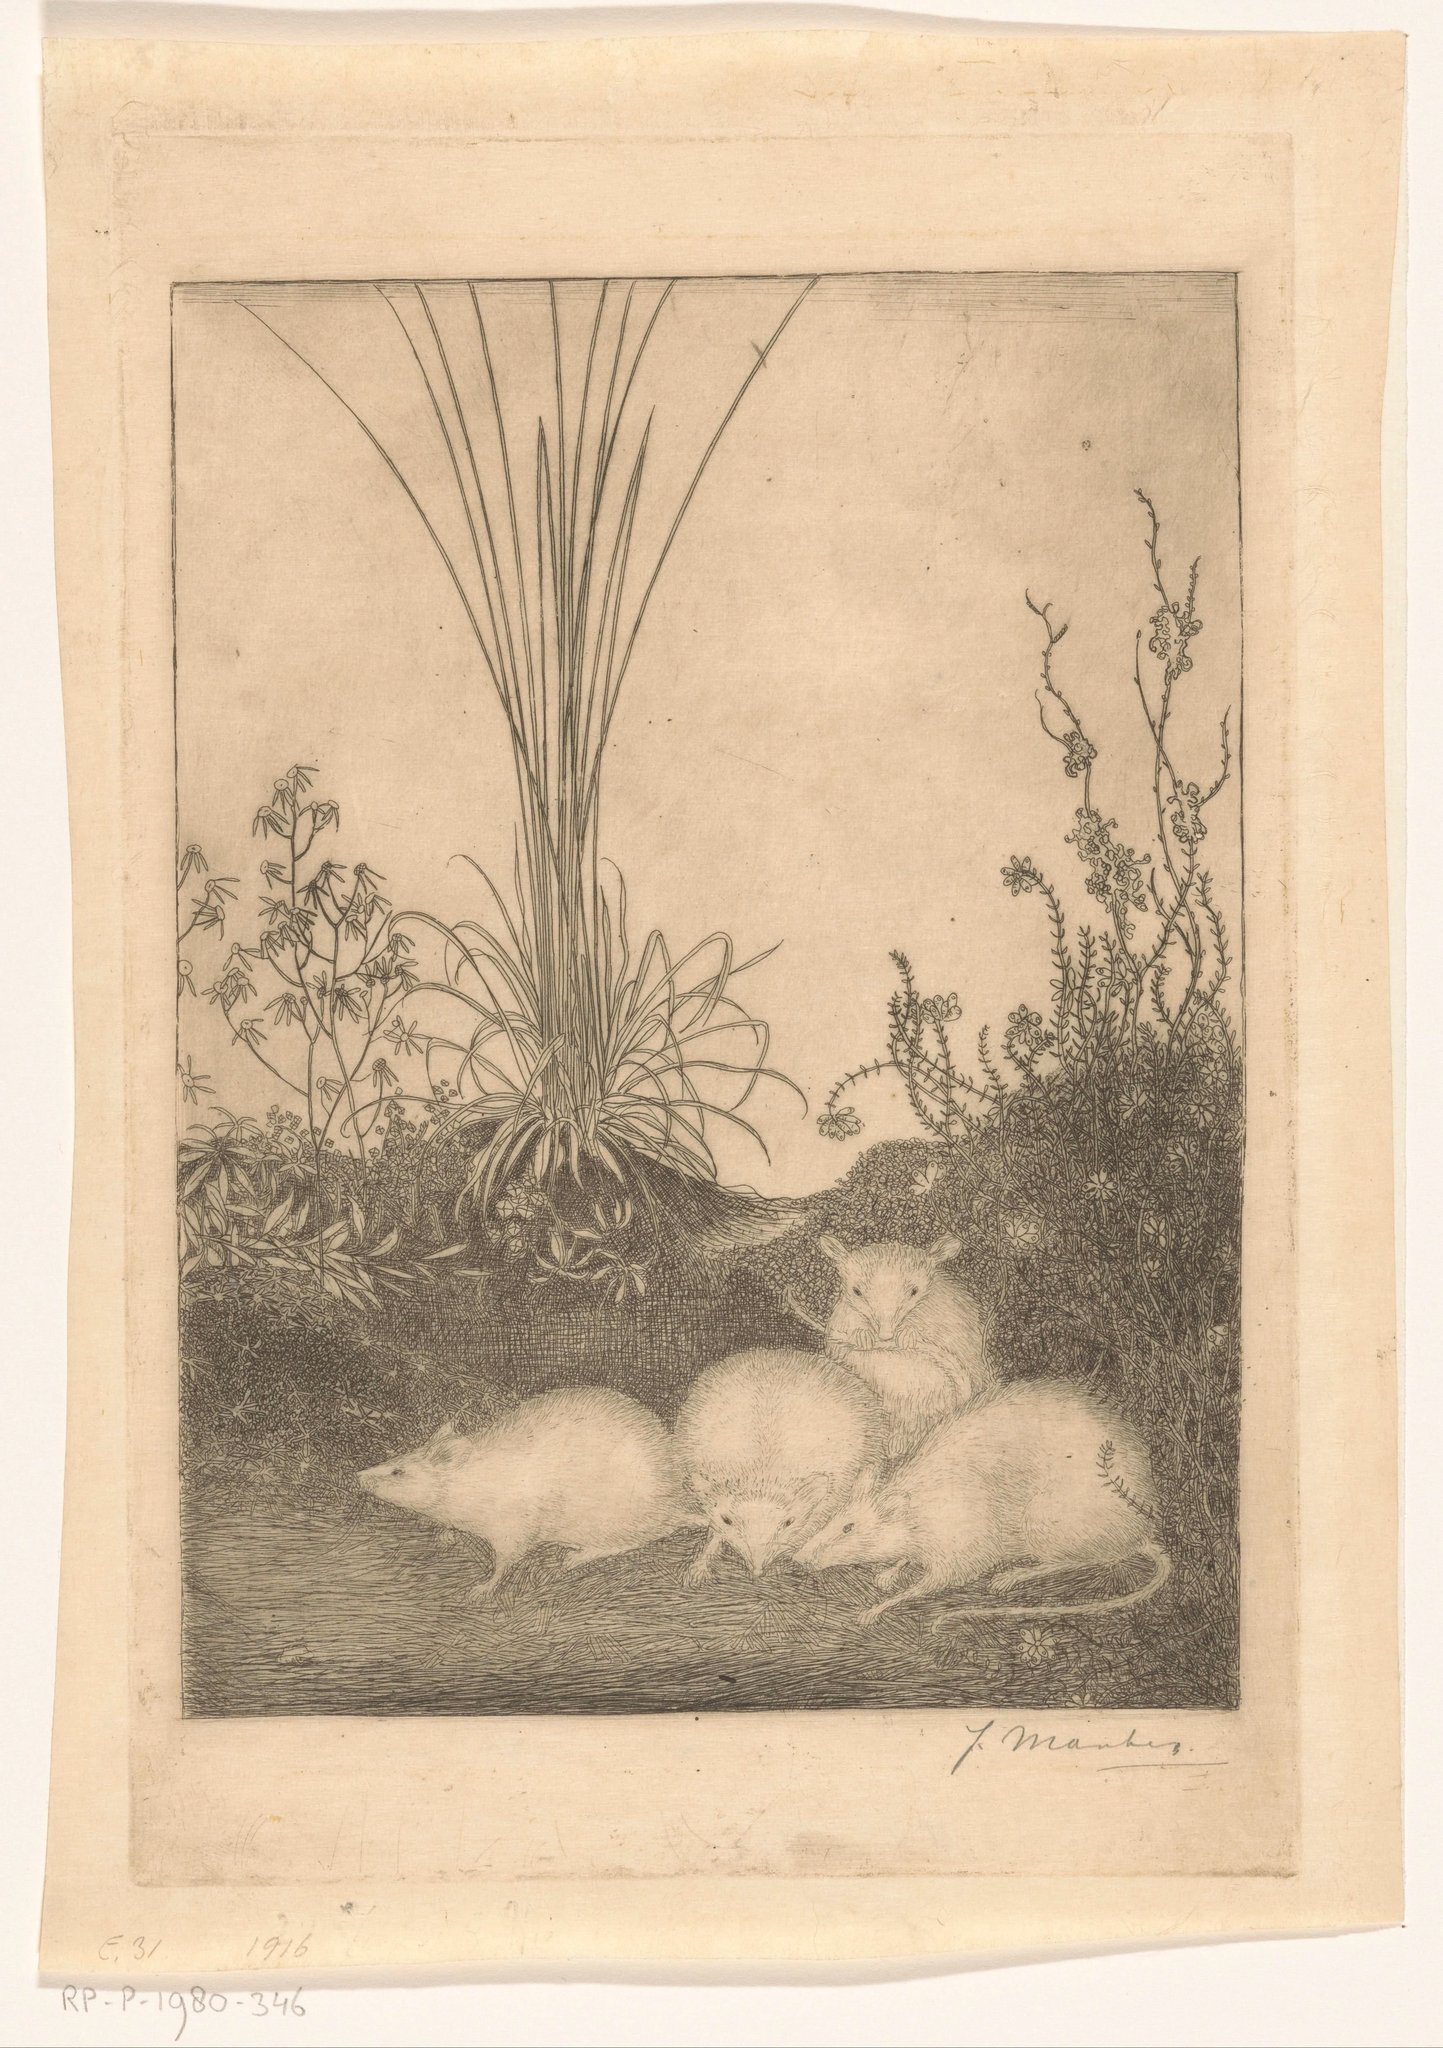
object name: print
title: Vier muizen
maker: jan mankes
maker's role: draughtsman, painter, print maker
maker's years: 1889-1920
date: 1916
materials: paper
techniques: etching, intaglio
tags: groups of lower plants, rodents: mouse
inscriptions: collector's mark: Lugt 2228